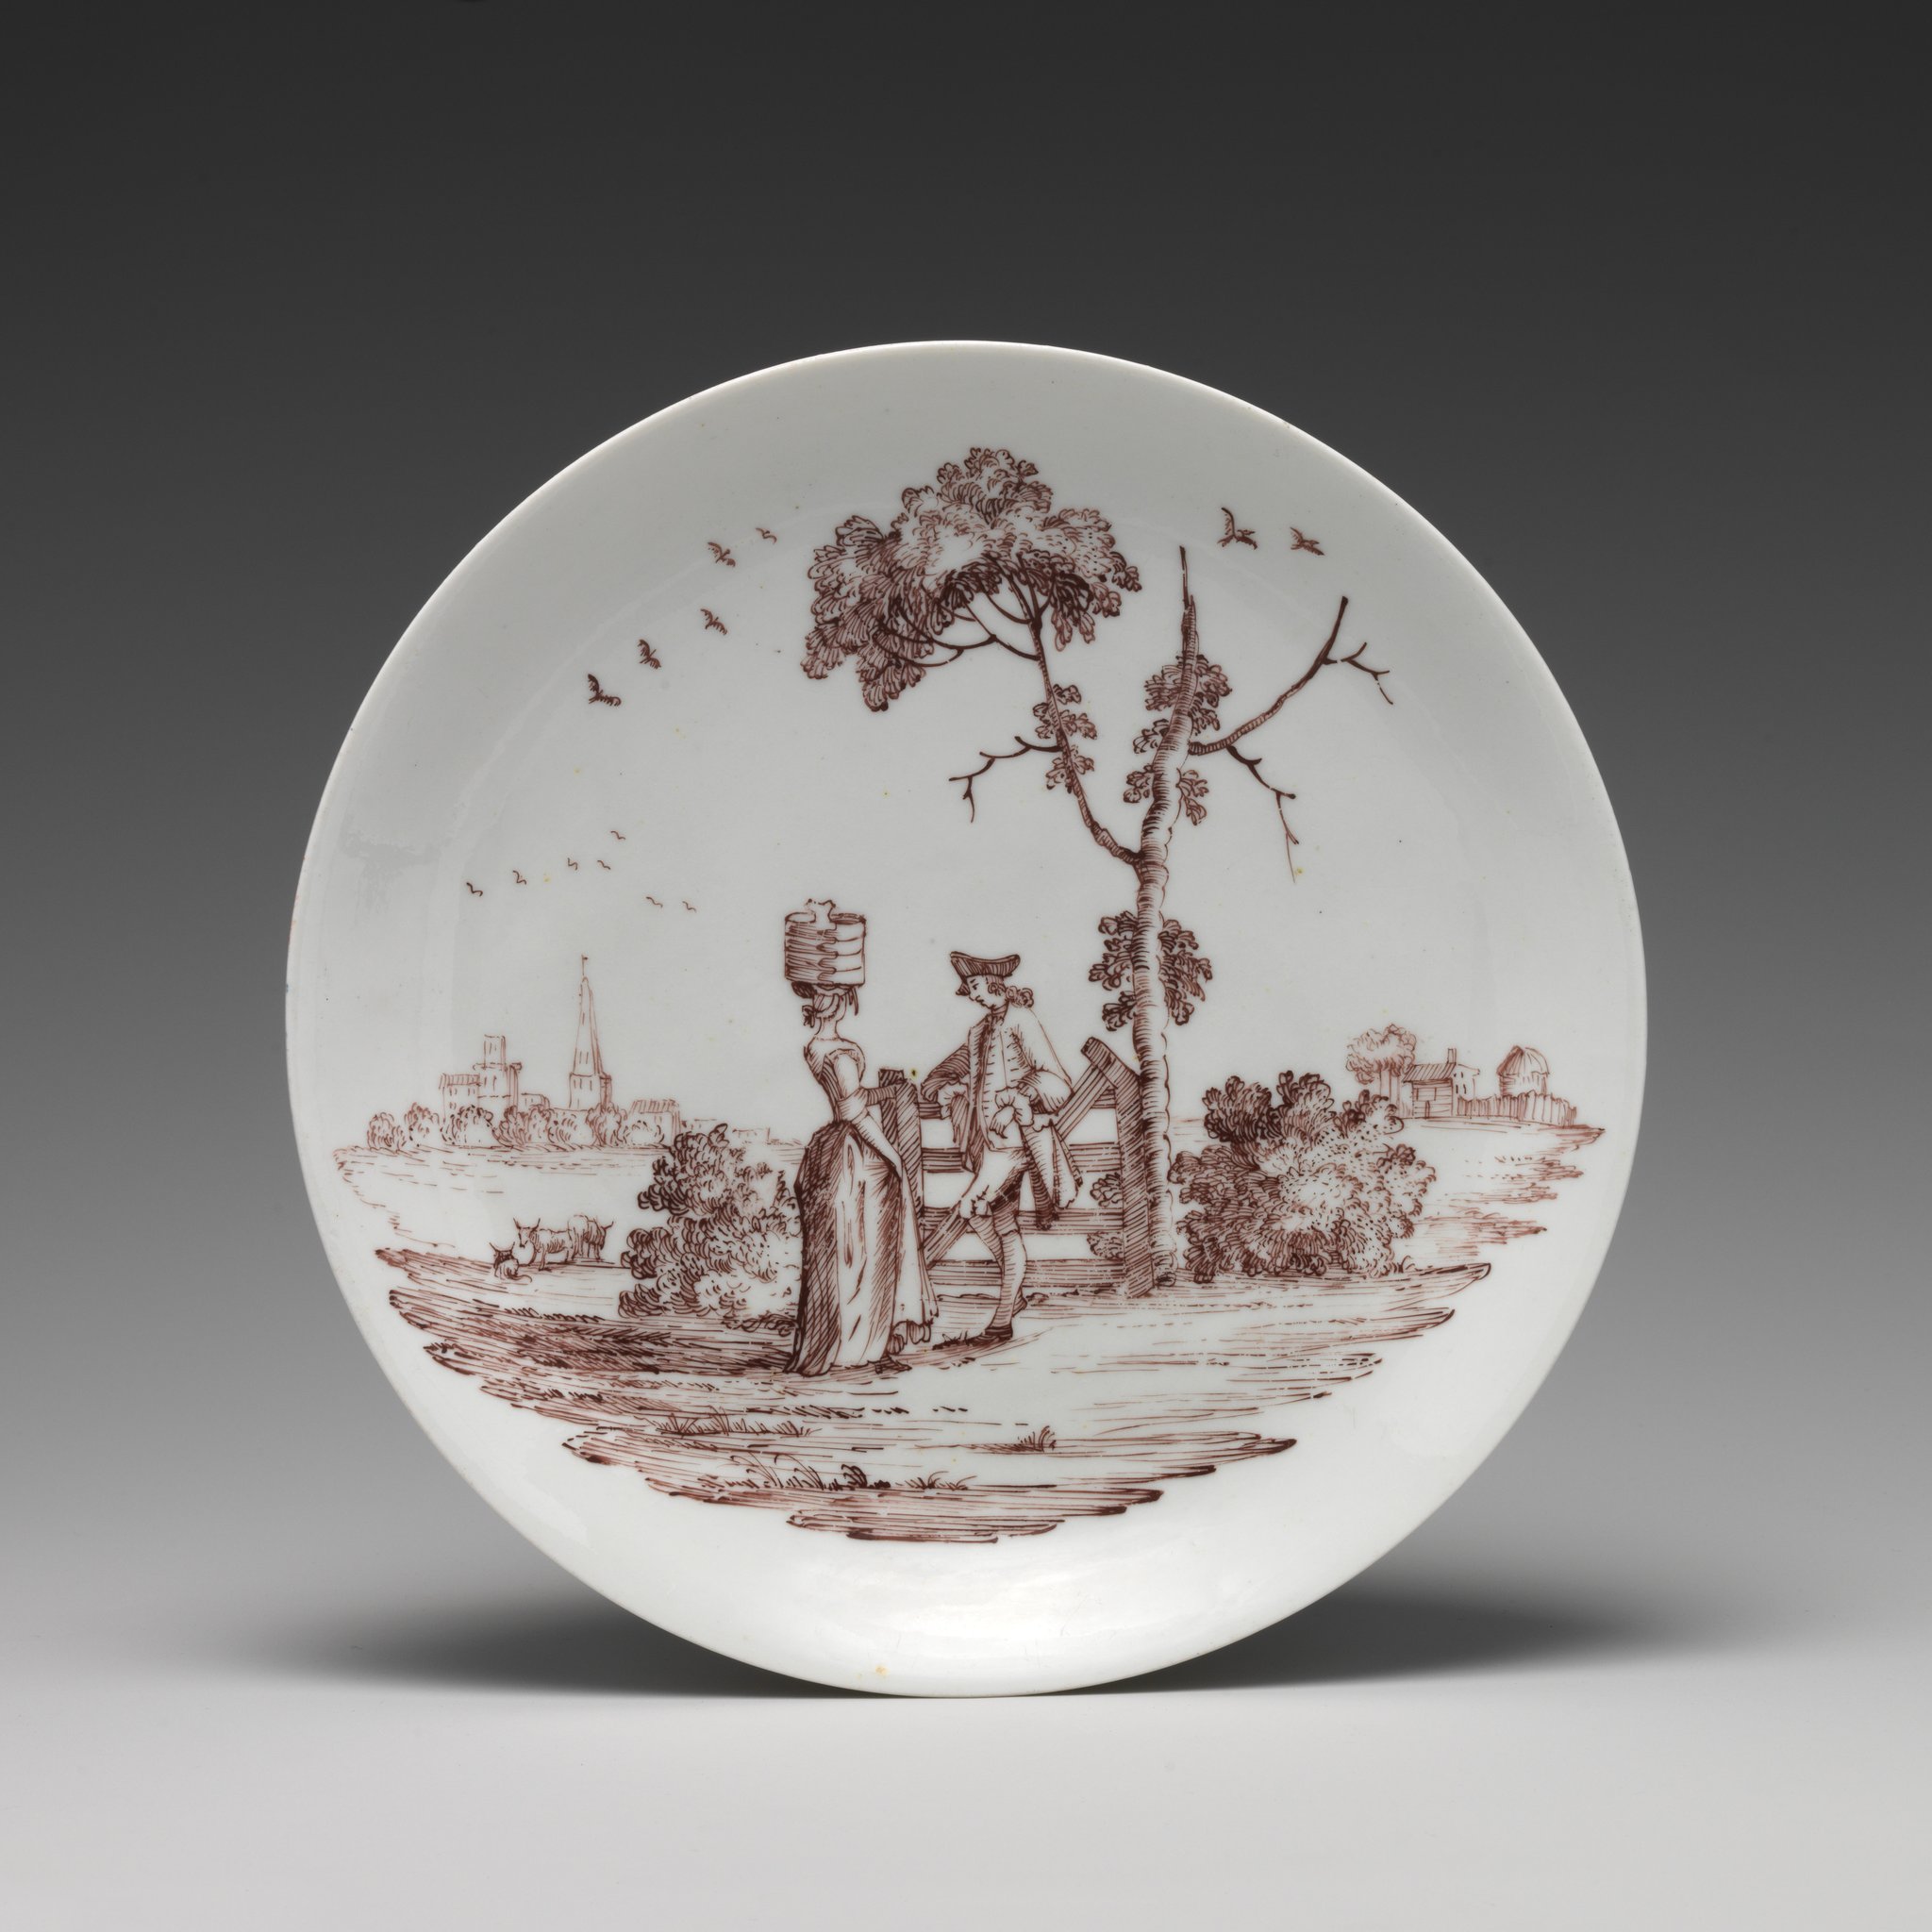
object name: dish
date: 1701-1800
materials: soft paste porcelain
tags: birds,men,women,landscapes